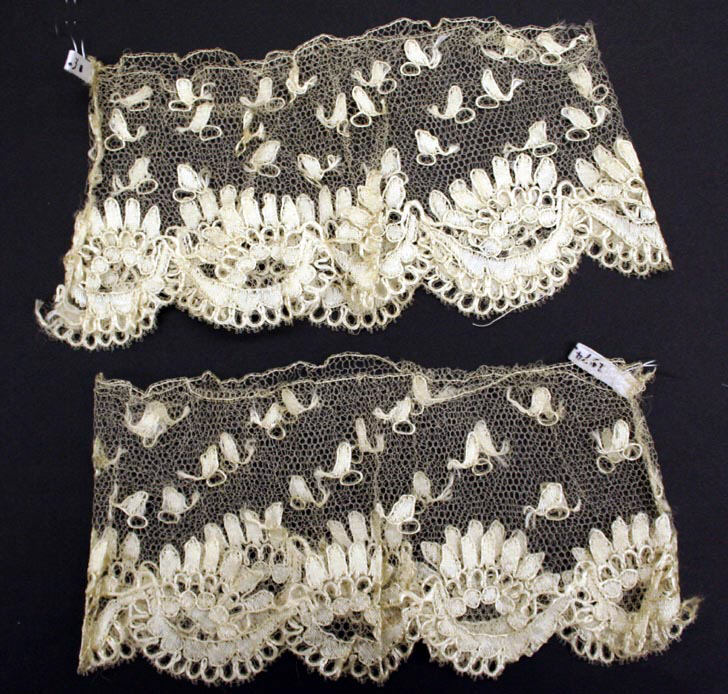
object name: cuff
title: Cuffs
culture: spanish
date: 1801-1900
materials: silk